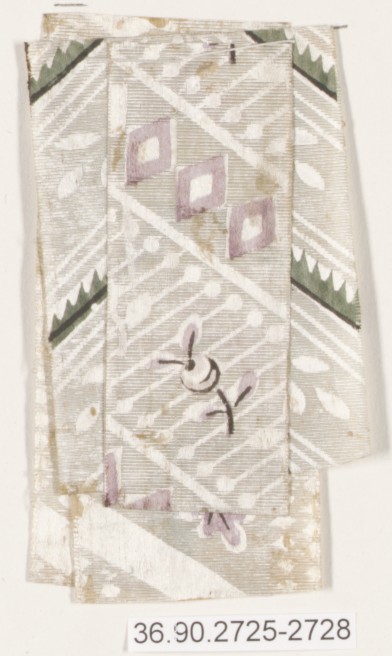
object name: ribbon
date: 1801-1900